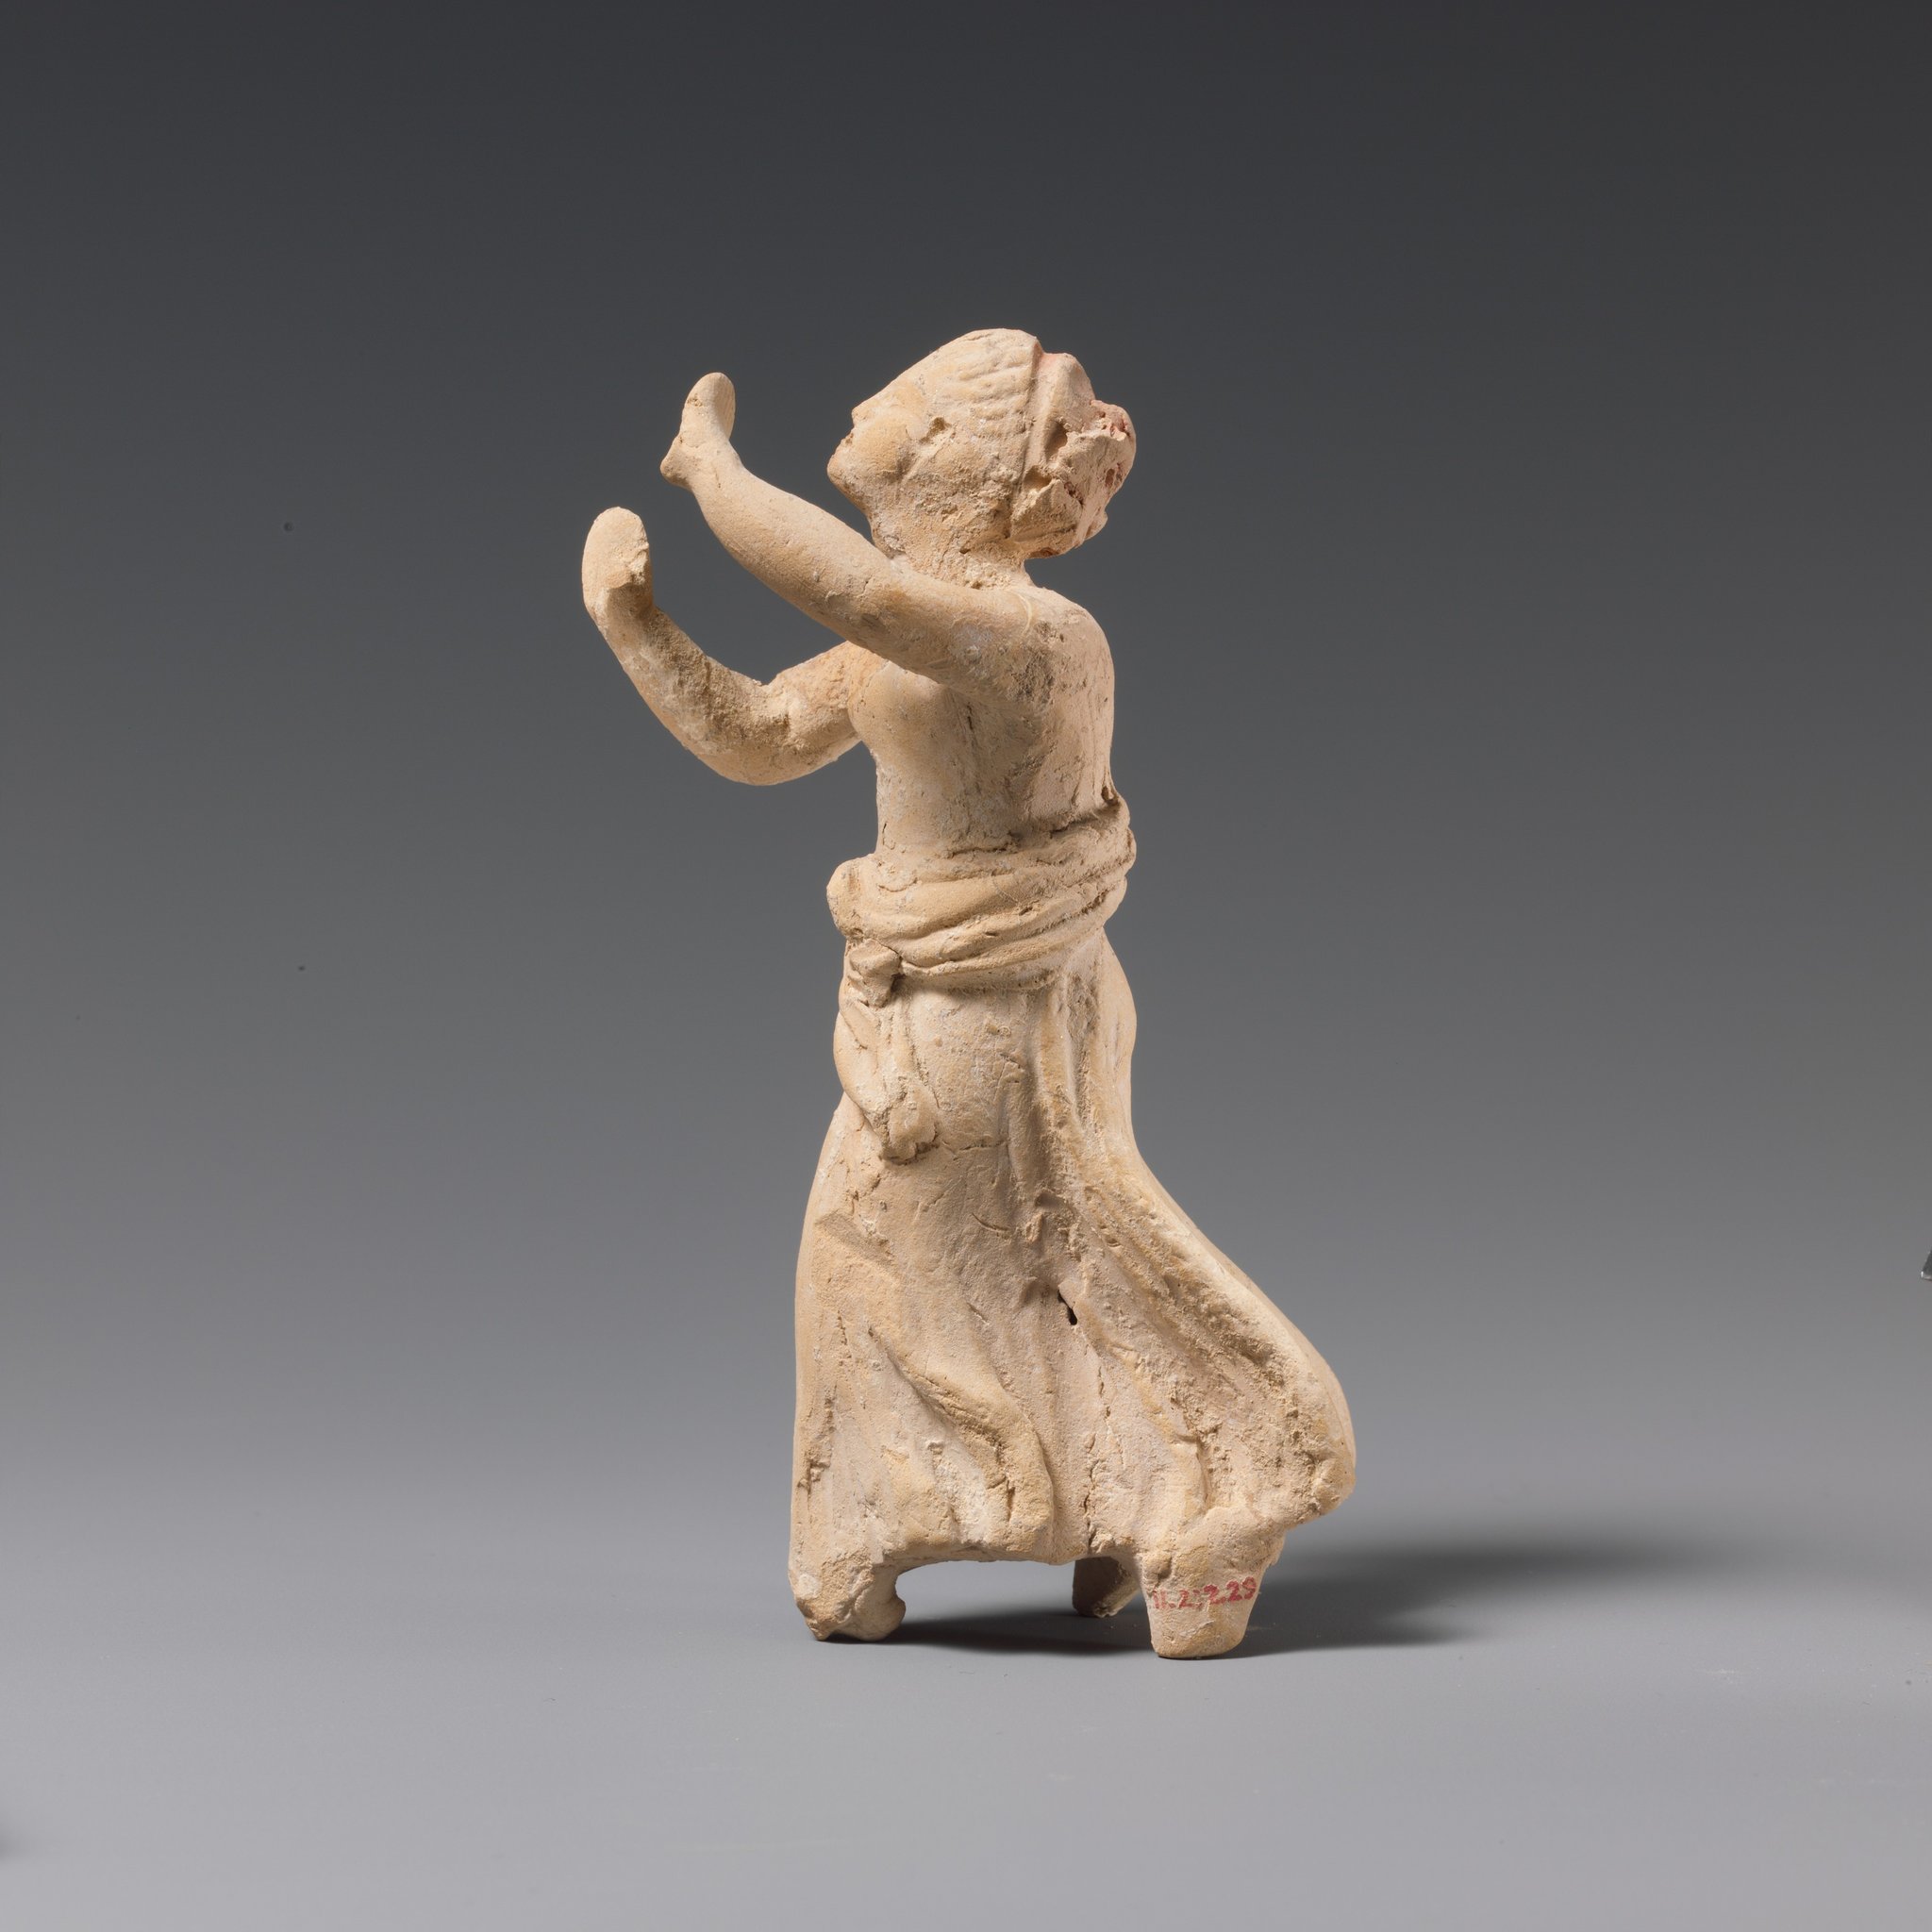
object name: statuette of a girl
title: Terracotta statuette of a girl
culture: greek, south italian, tarentine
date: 300-201 BCE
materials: terracotta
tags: girls